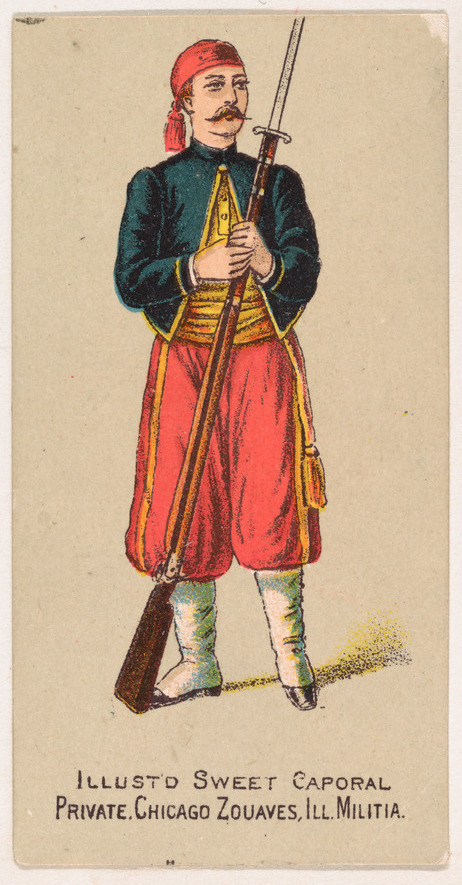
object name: print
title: Private, Chicago Zouaves, Illinois MIlitia, from the Military Series (N224) issued by Kinney Tobacco Company to promote Sweet Caporal Cigarettes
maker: kinney brothers tobacco company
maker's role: publisher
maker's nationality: american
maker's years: 1869-2011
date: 1888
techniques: color lithograph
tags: military,men